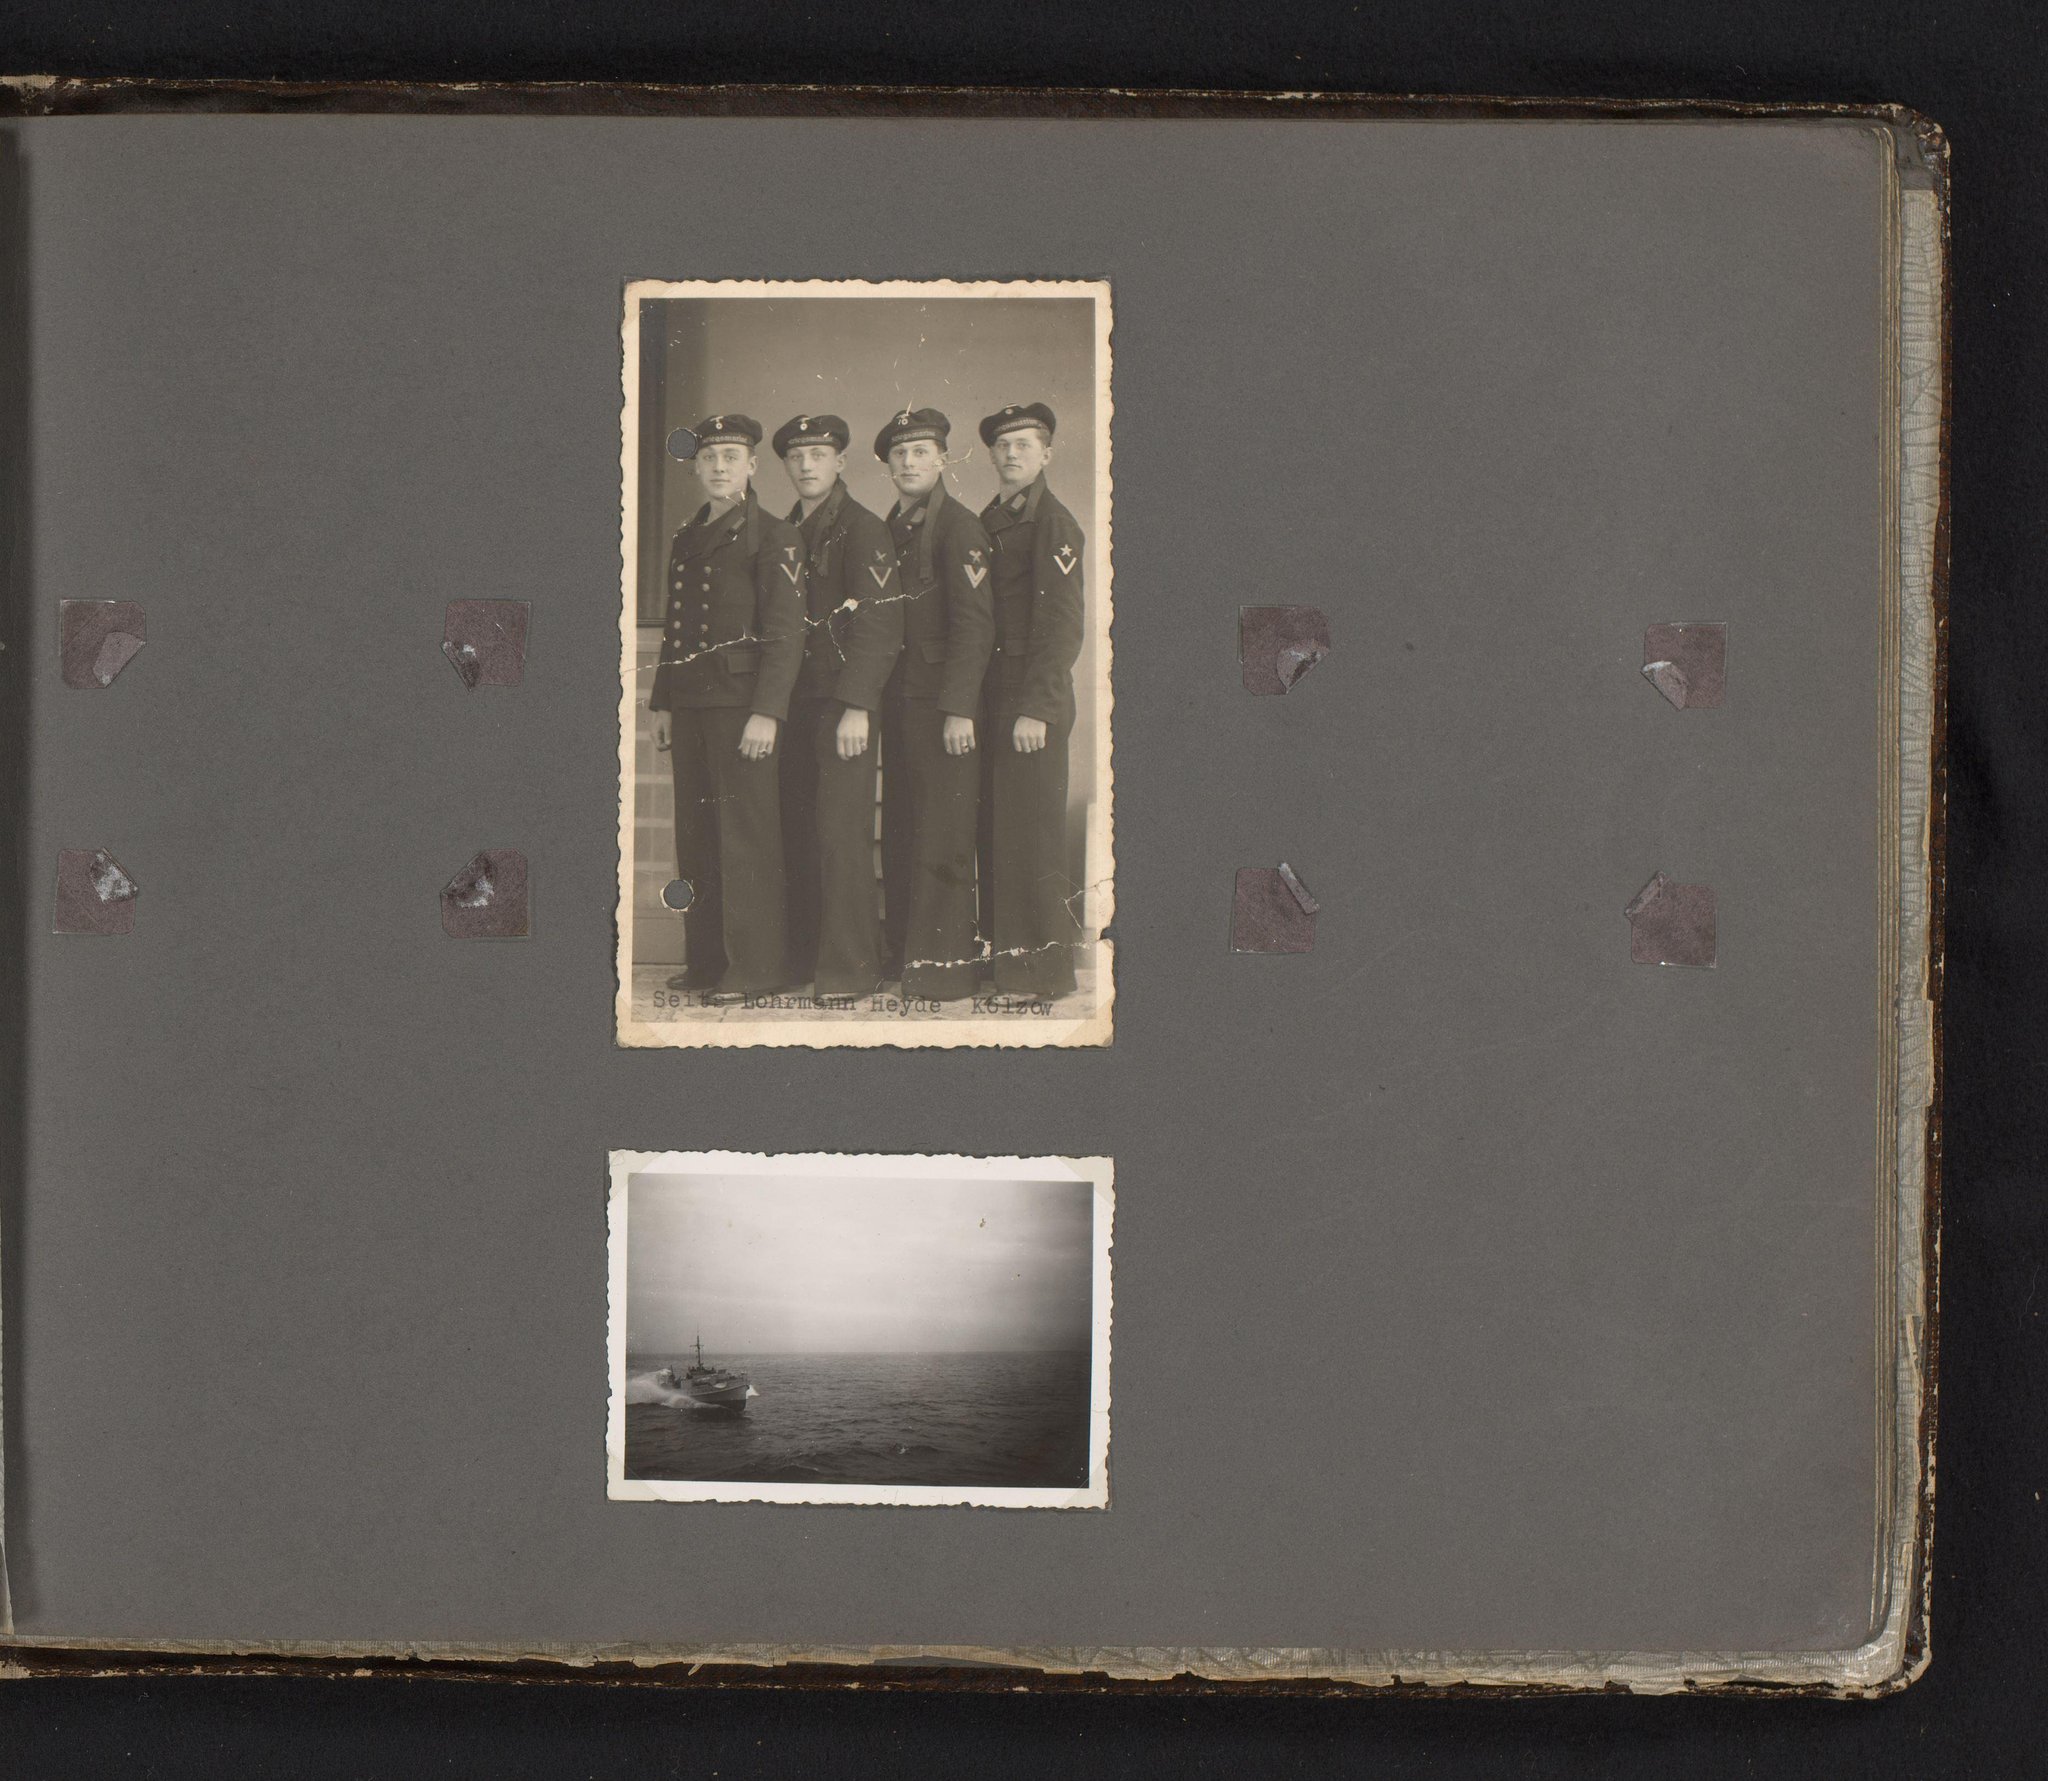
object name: photograph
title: Vrienden en schip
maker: Anonymous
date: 1939-1942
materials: paper, photographic support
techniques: gelatin silver print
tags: the company, the unit, the troop ~ military service, navy (+ motor ships), sailor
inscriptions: inscription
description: Albumblad met twee foto's van vier matrozen (met namen) van de Kriegsmarine en van een schip op zee. Onderdeel van het fotoalbum Kriegsmarine.